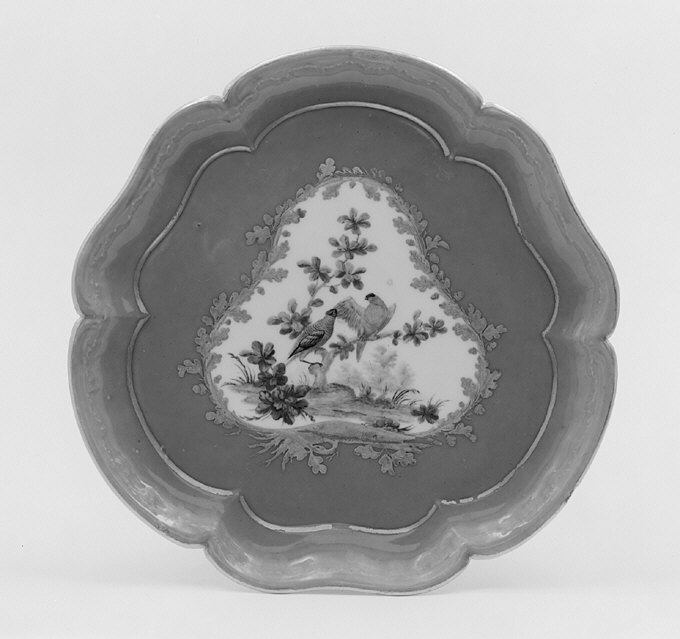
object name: stand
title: Stand for ice-cream cups (plateau Bourets) (one of four) (part of a service)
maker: sèvres manufactory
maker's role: manufactory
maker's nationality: french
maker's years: 1740-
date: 1771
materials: soft paste porcelain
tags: birds,flowers,trees